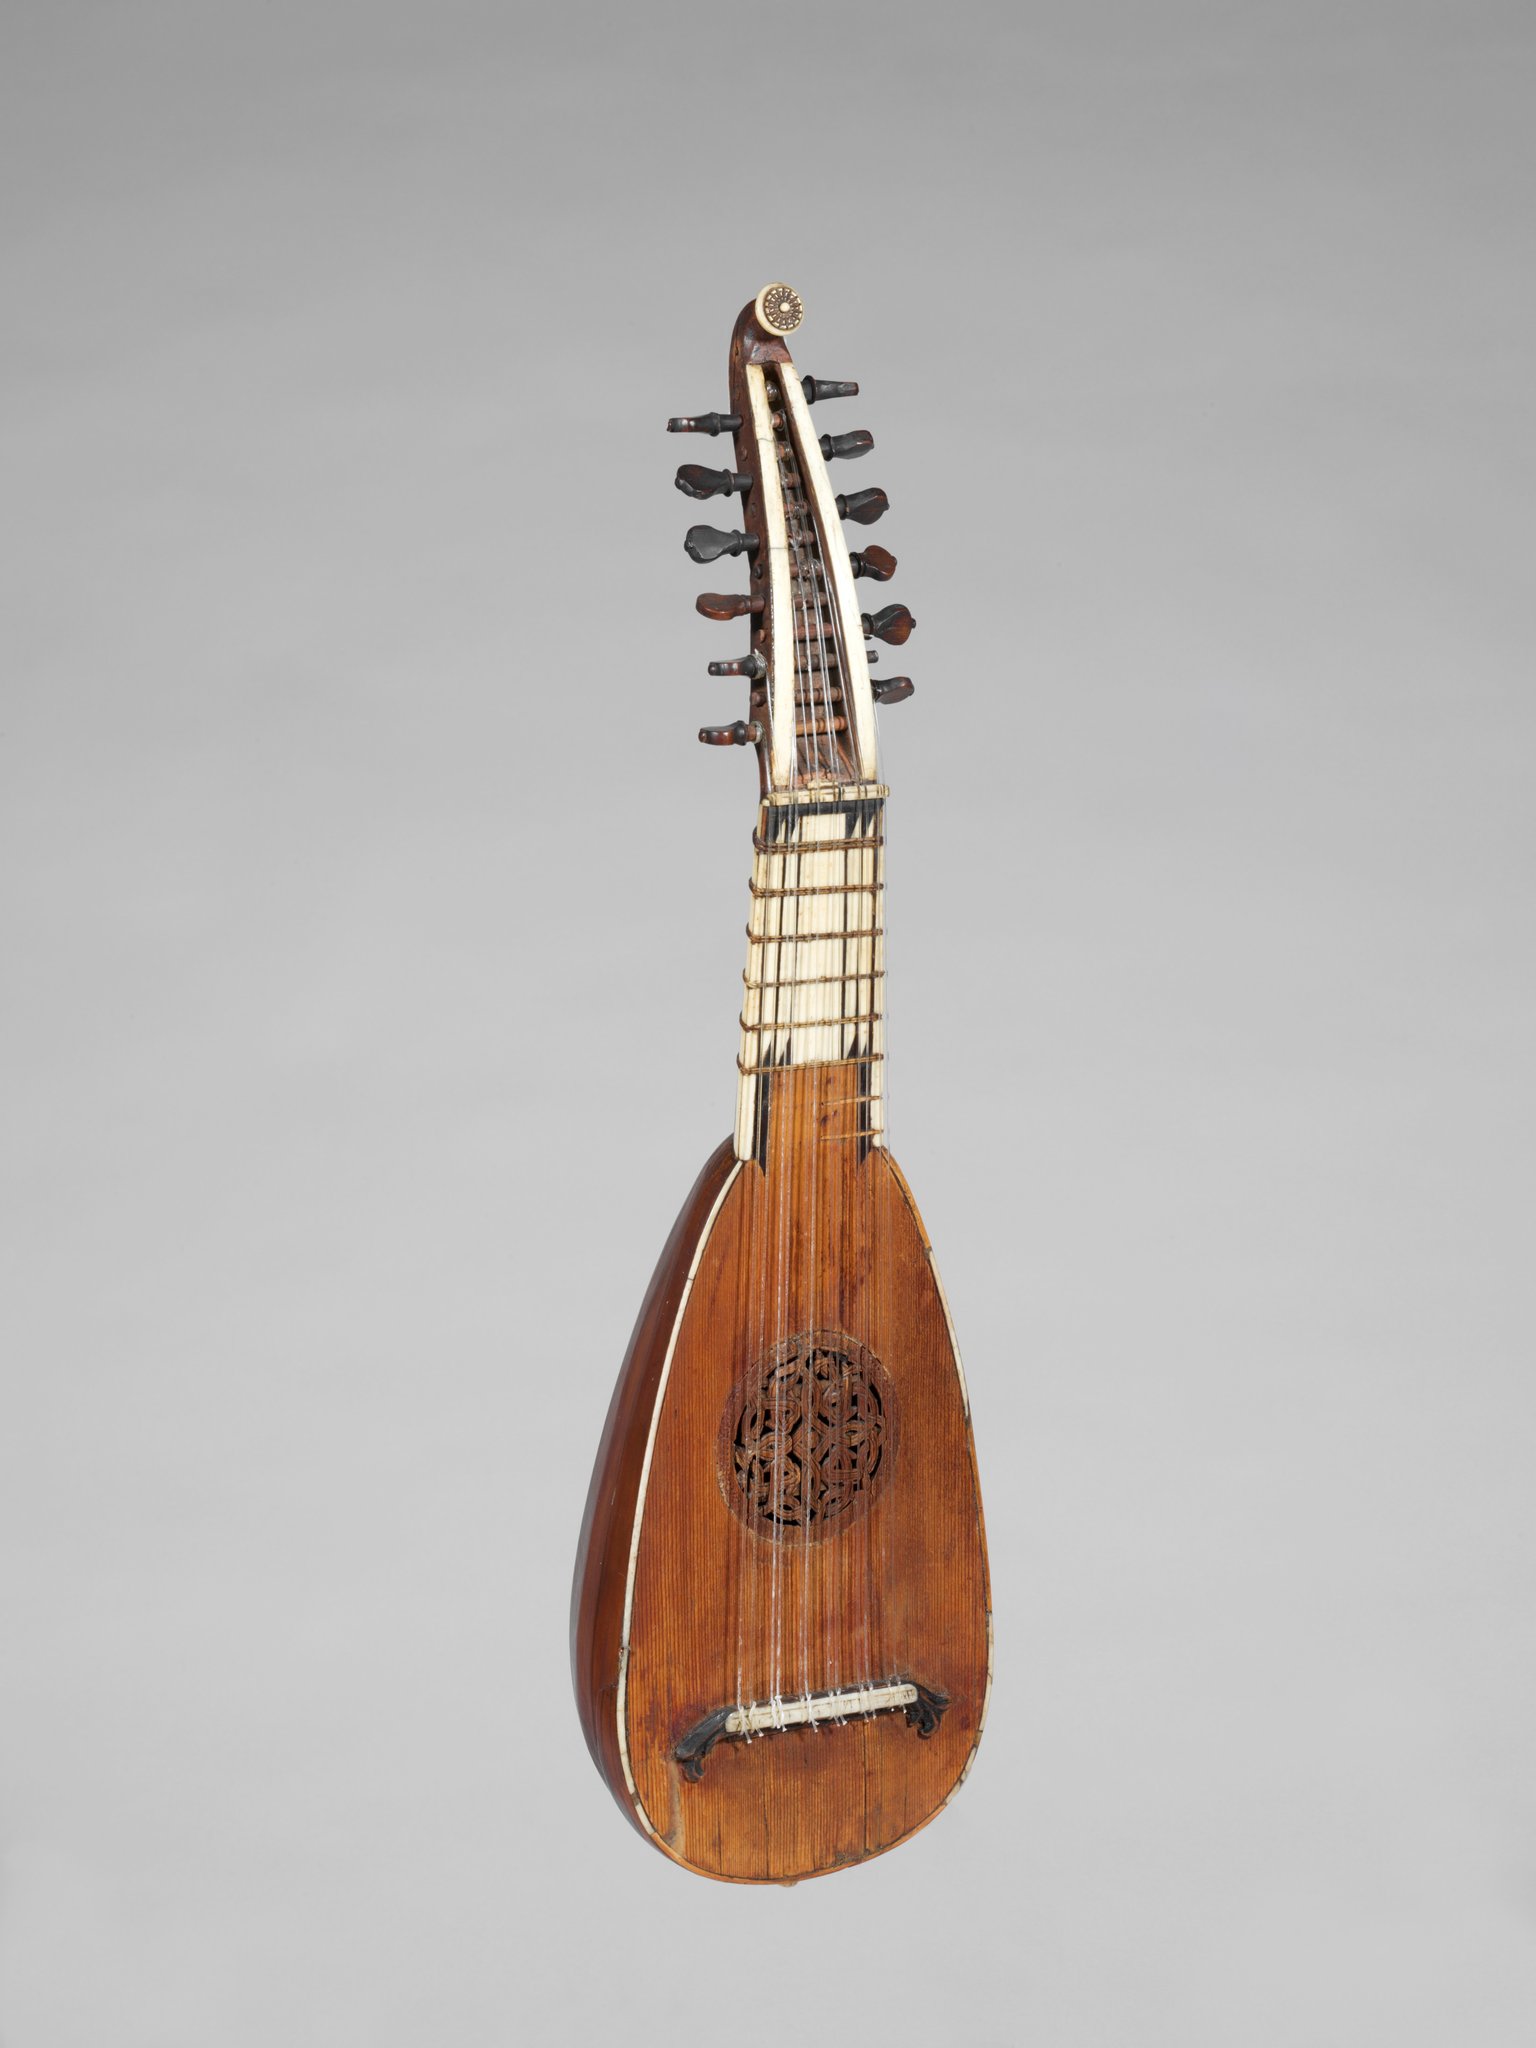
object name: mandolin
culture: italian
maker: giovanni battista bizaro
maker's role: maker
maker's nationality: italian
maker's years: 1770-1780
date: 1770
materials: bone, wood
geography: italy